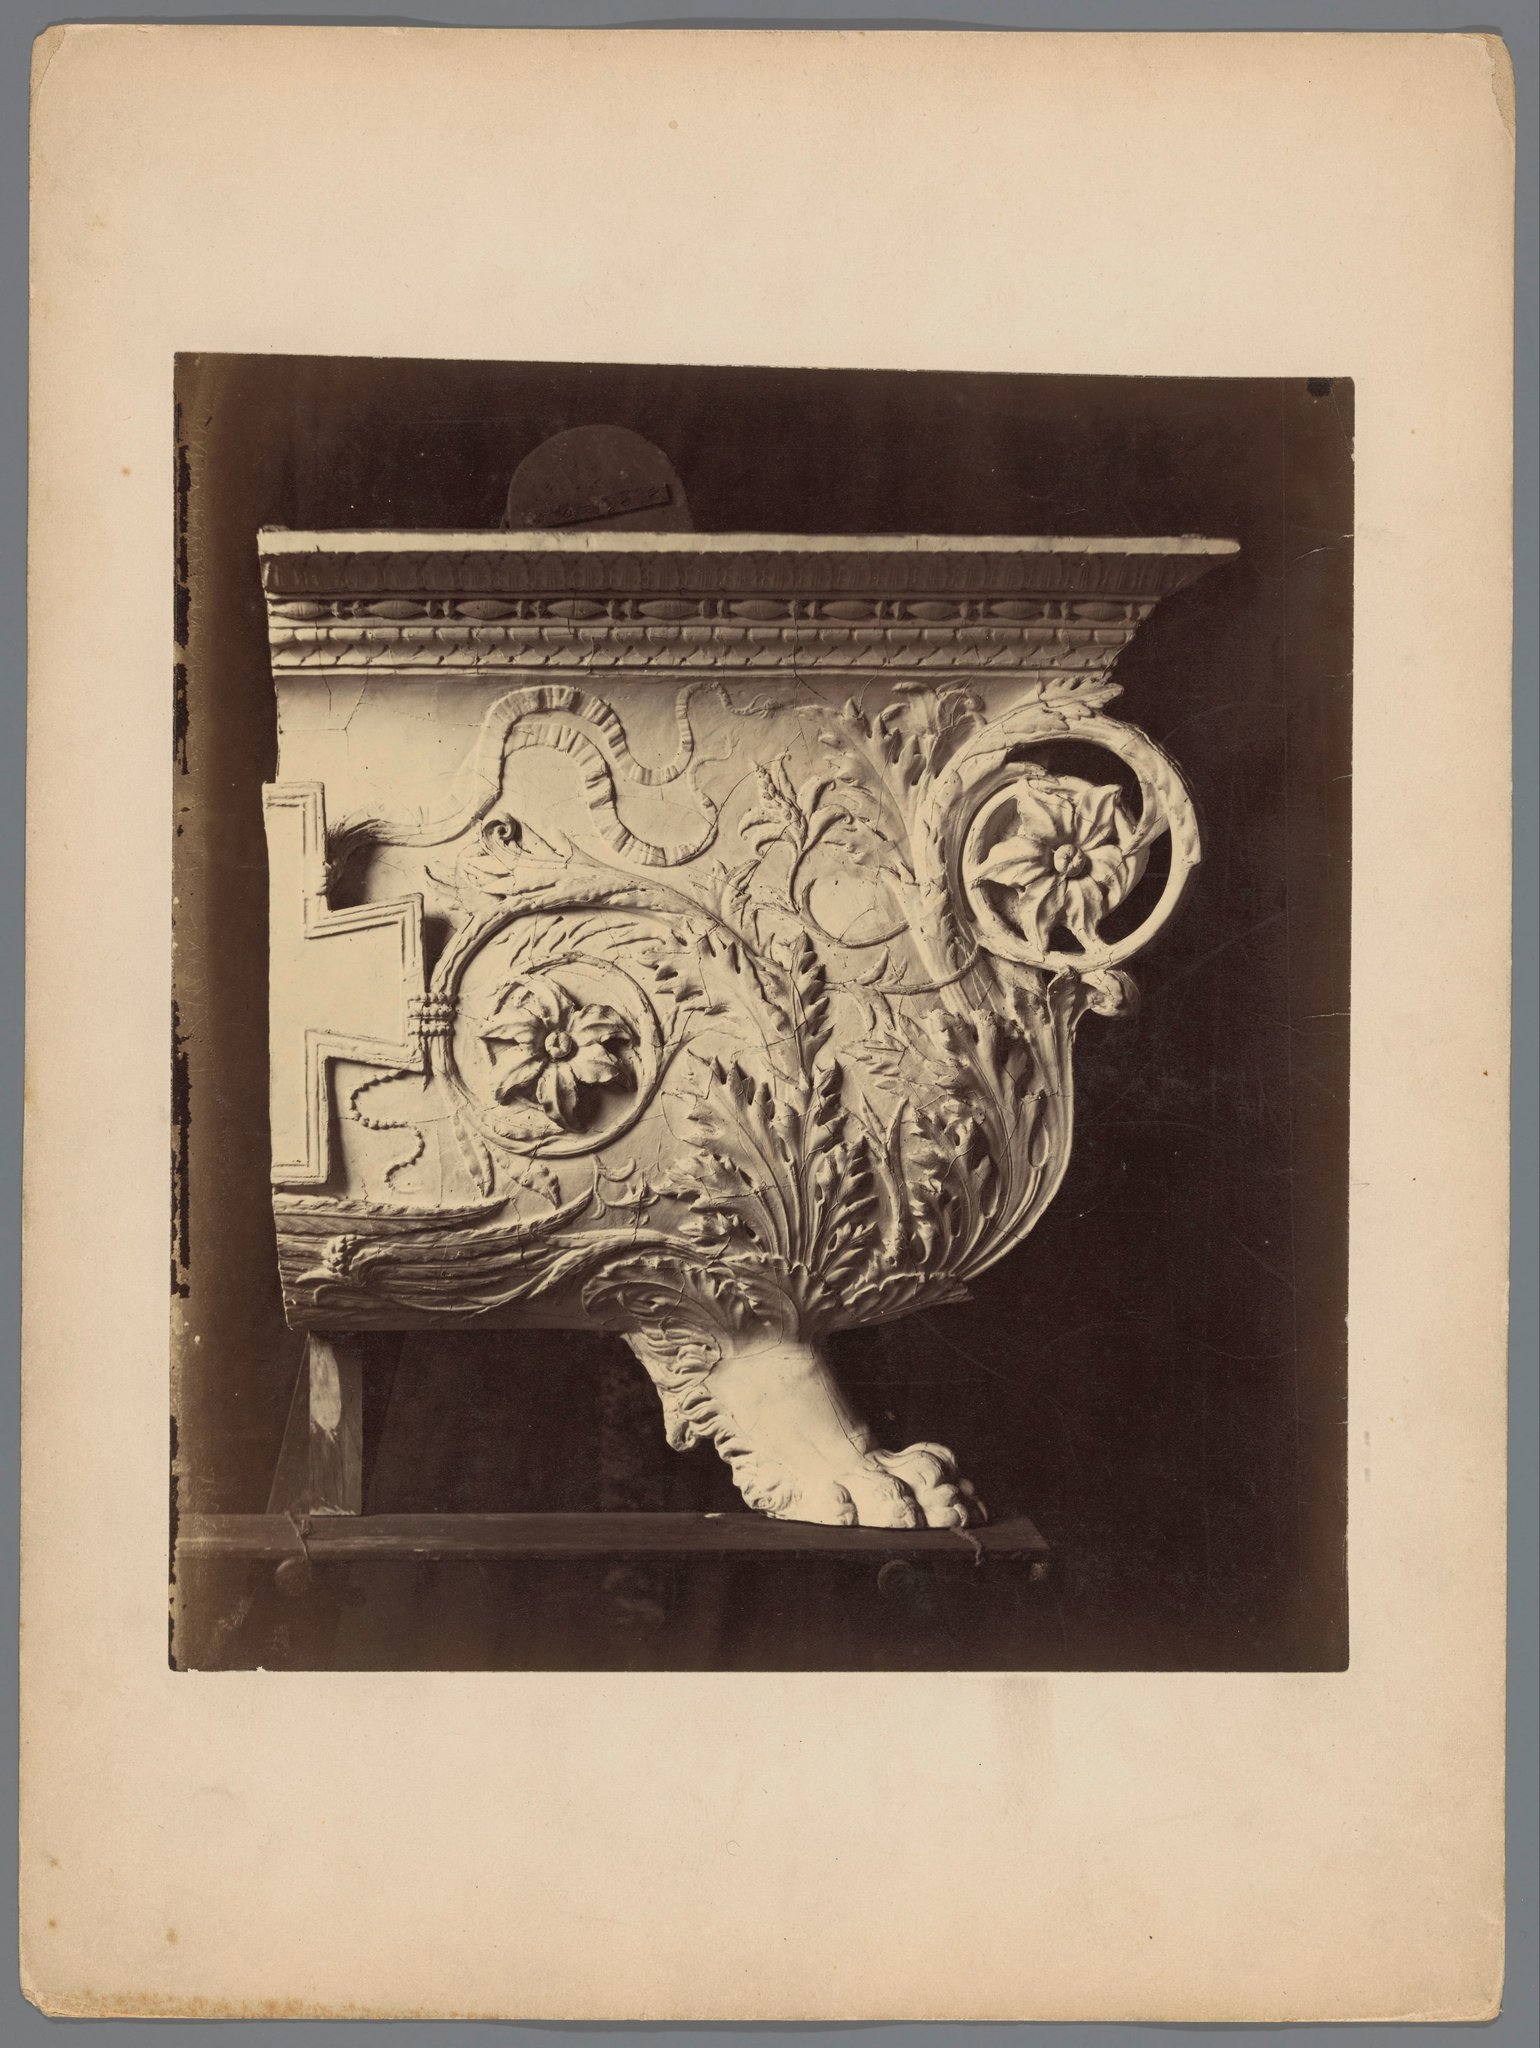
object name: photograph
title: Deel van een (vermoedelijk) gipsmodel voor een kist met een bloemmotief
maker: Anonymous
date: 1875-1900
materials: cardboard, photographic support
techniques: albumen print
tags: model ~ architecture (+ plaster ~ arts), flowers ~ ornament, sculpture (+ relief ~ sculpture)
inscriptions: collector's mark: Lugt 3937